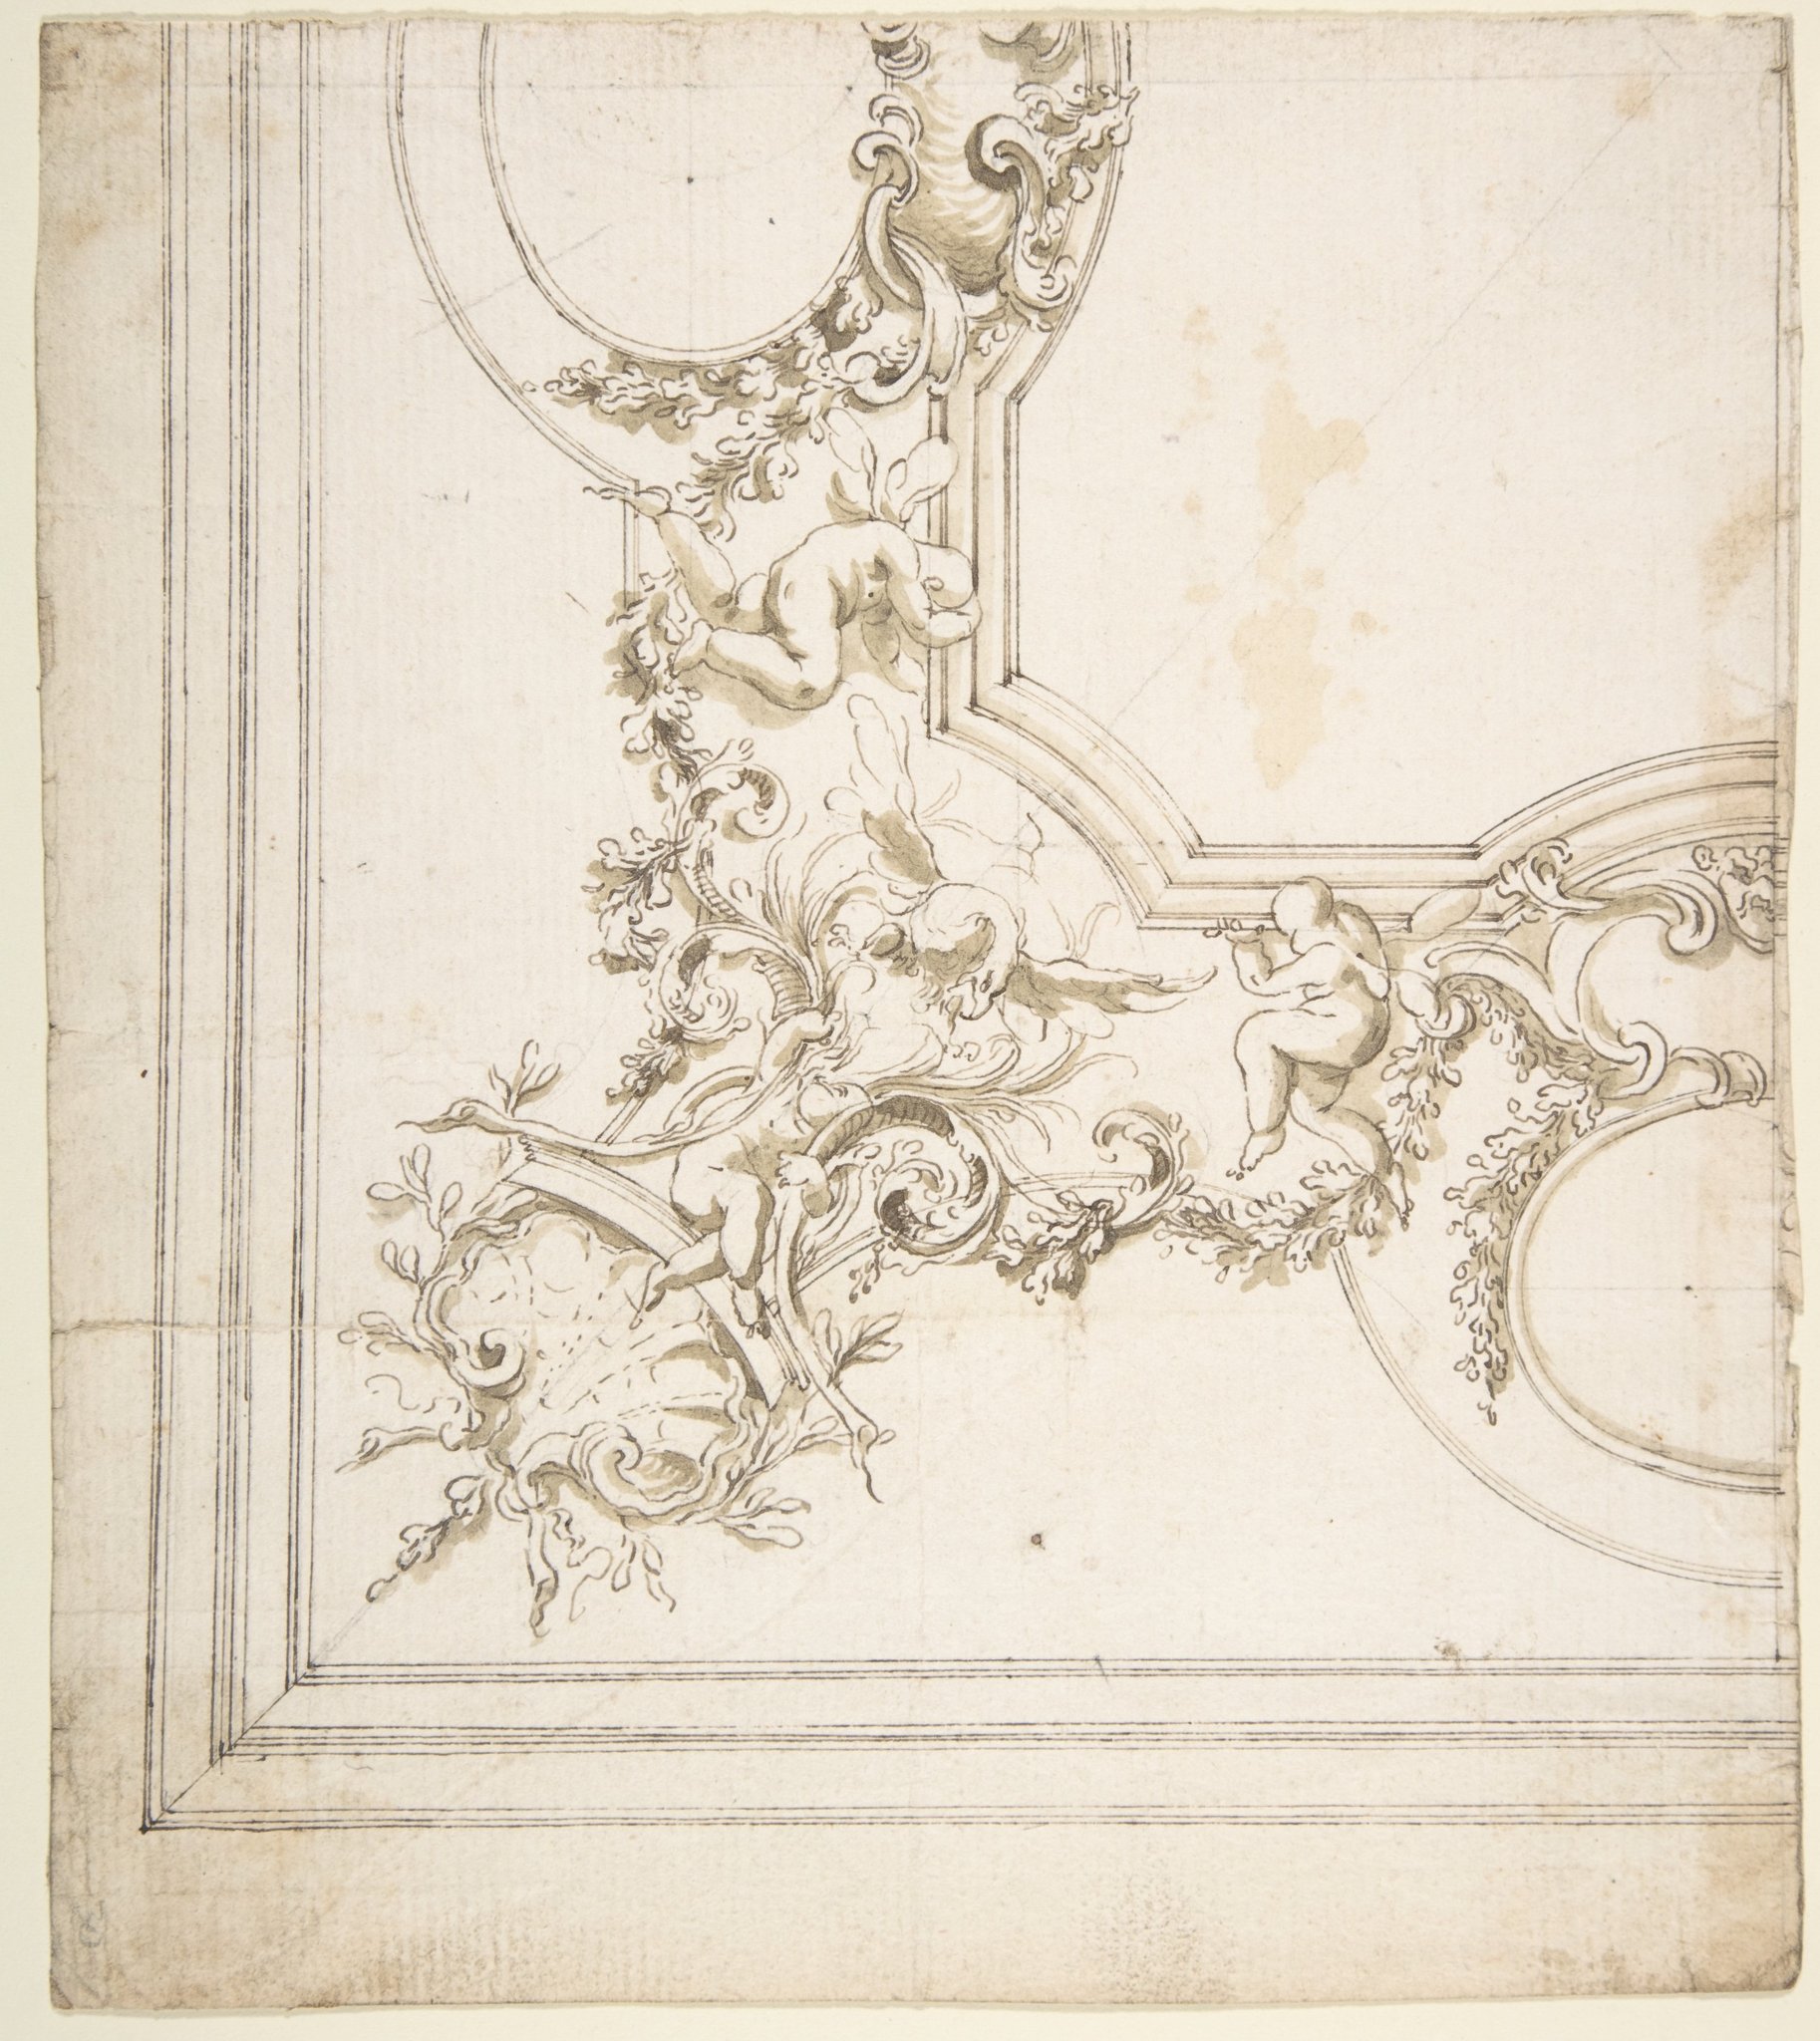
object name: drawing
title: Design for a Ceiling Decoration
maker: donato giuseppe frisoni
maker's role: artist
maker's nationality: italian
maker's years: 1683-1735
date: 1709-1720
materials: graphite, ink, drawing material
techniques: brush, pen, wash